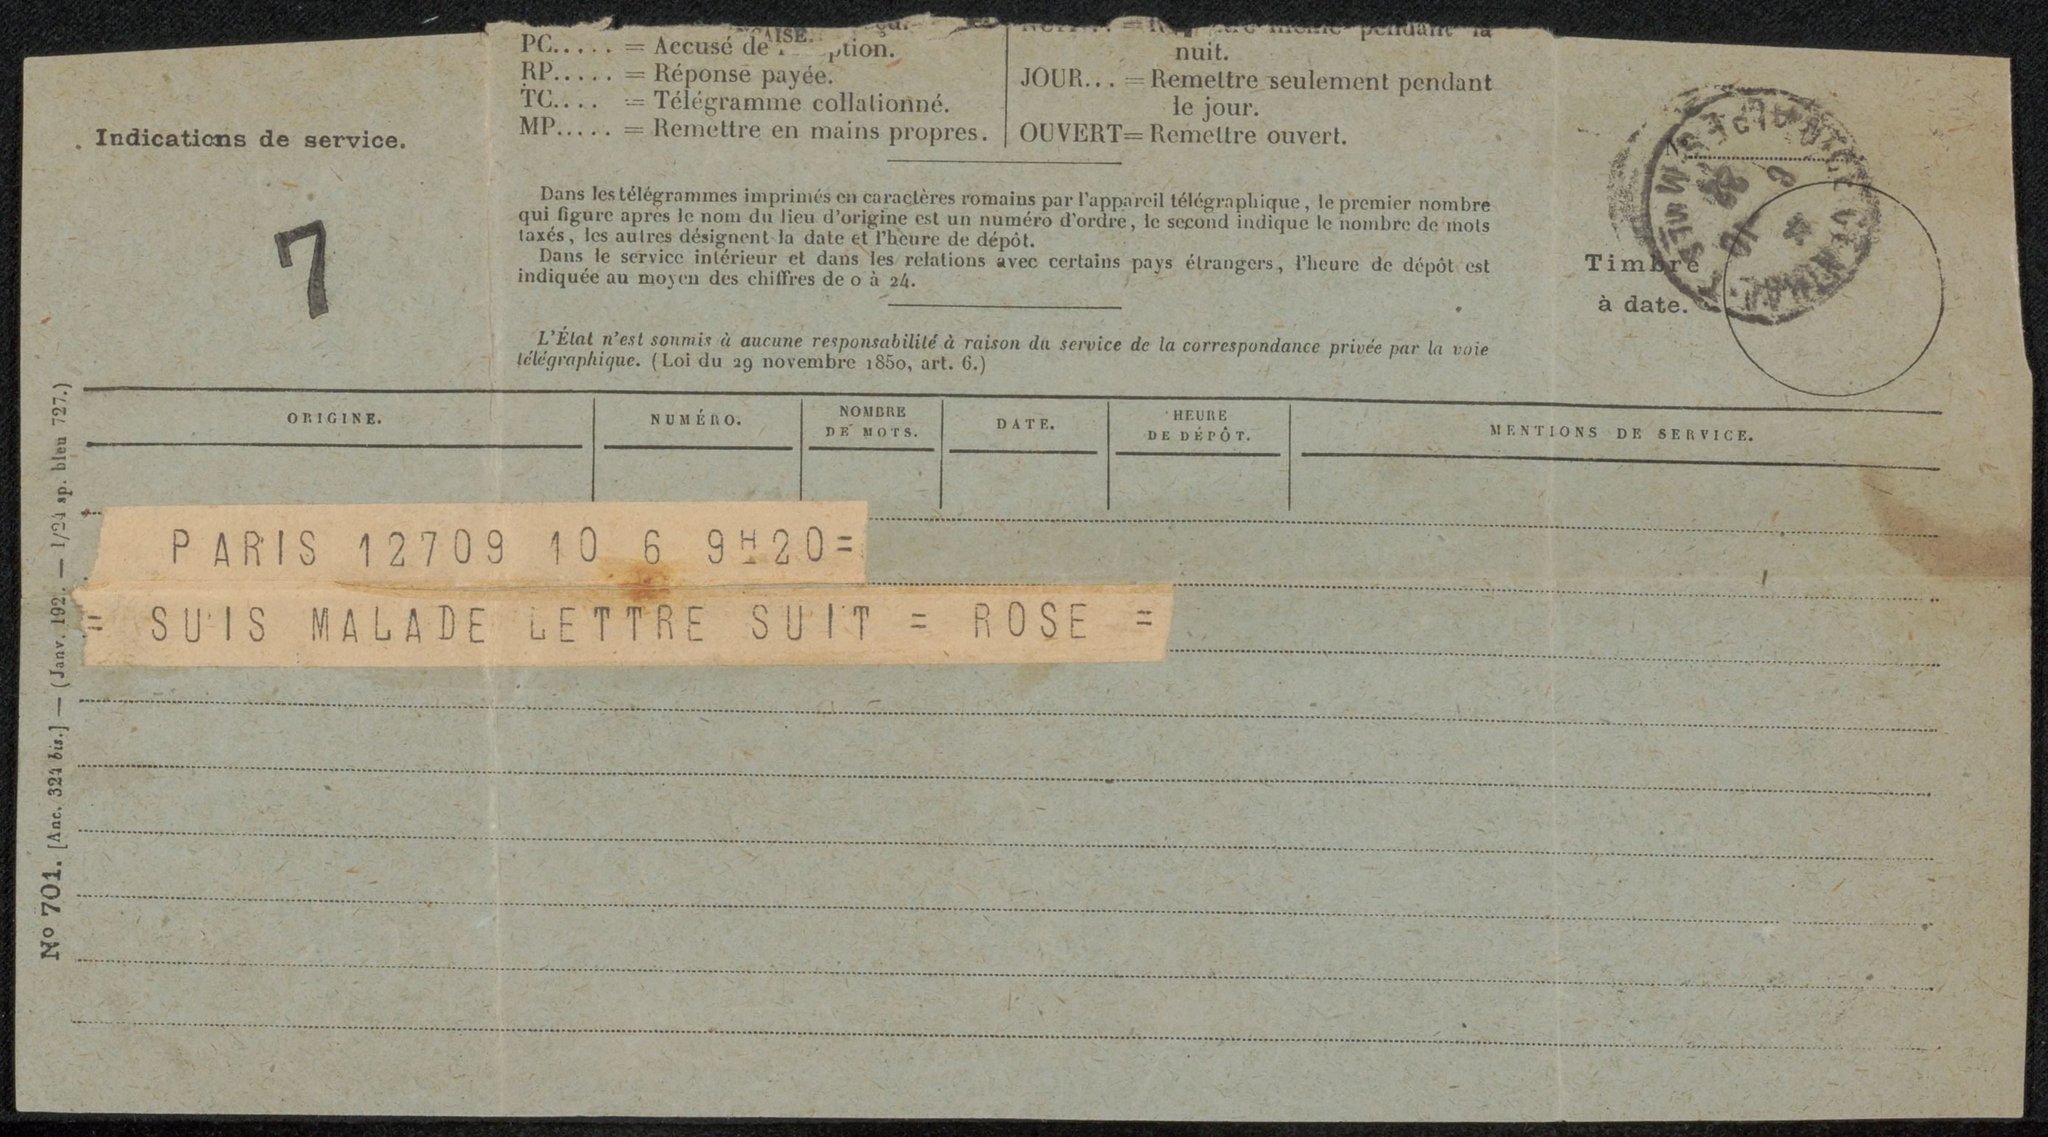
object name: telegram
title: Telegram aan Philip Zilcken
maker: rose imel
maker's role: draughtsman, painter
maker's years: 1901-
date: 1922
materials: paper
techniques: printing, typewriting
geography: paris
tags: the hague, painter, draughtsman, philip zilcken, diseases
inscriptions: collector's mark: ‘RPK’